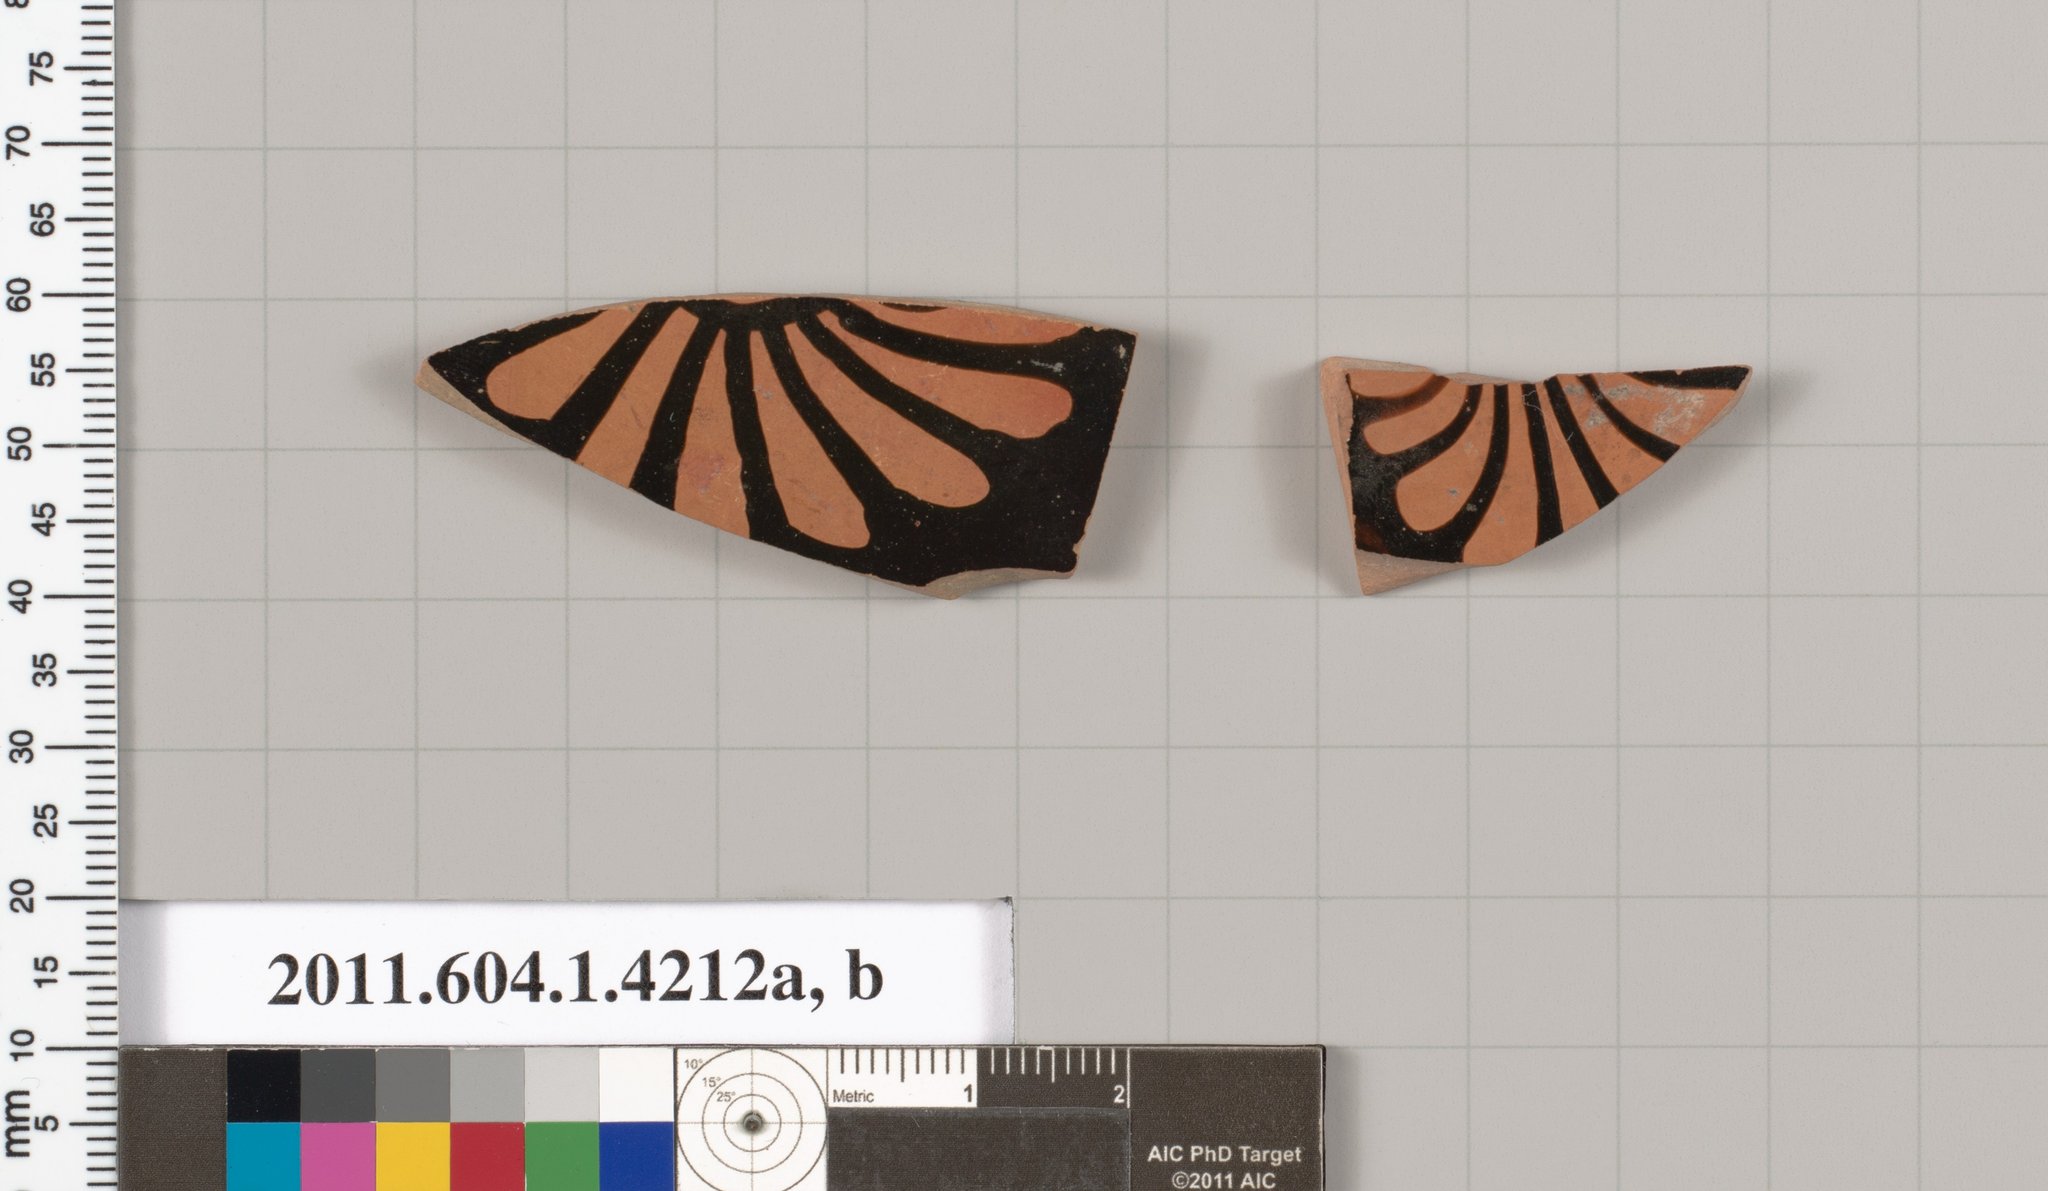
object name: kylix fragment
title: Terracotta fragments of kylikes (drinking cups)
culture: greek, attic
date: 475-451 BCE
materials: terracotta